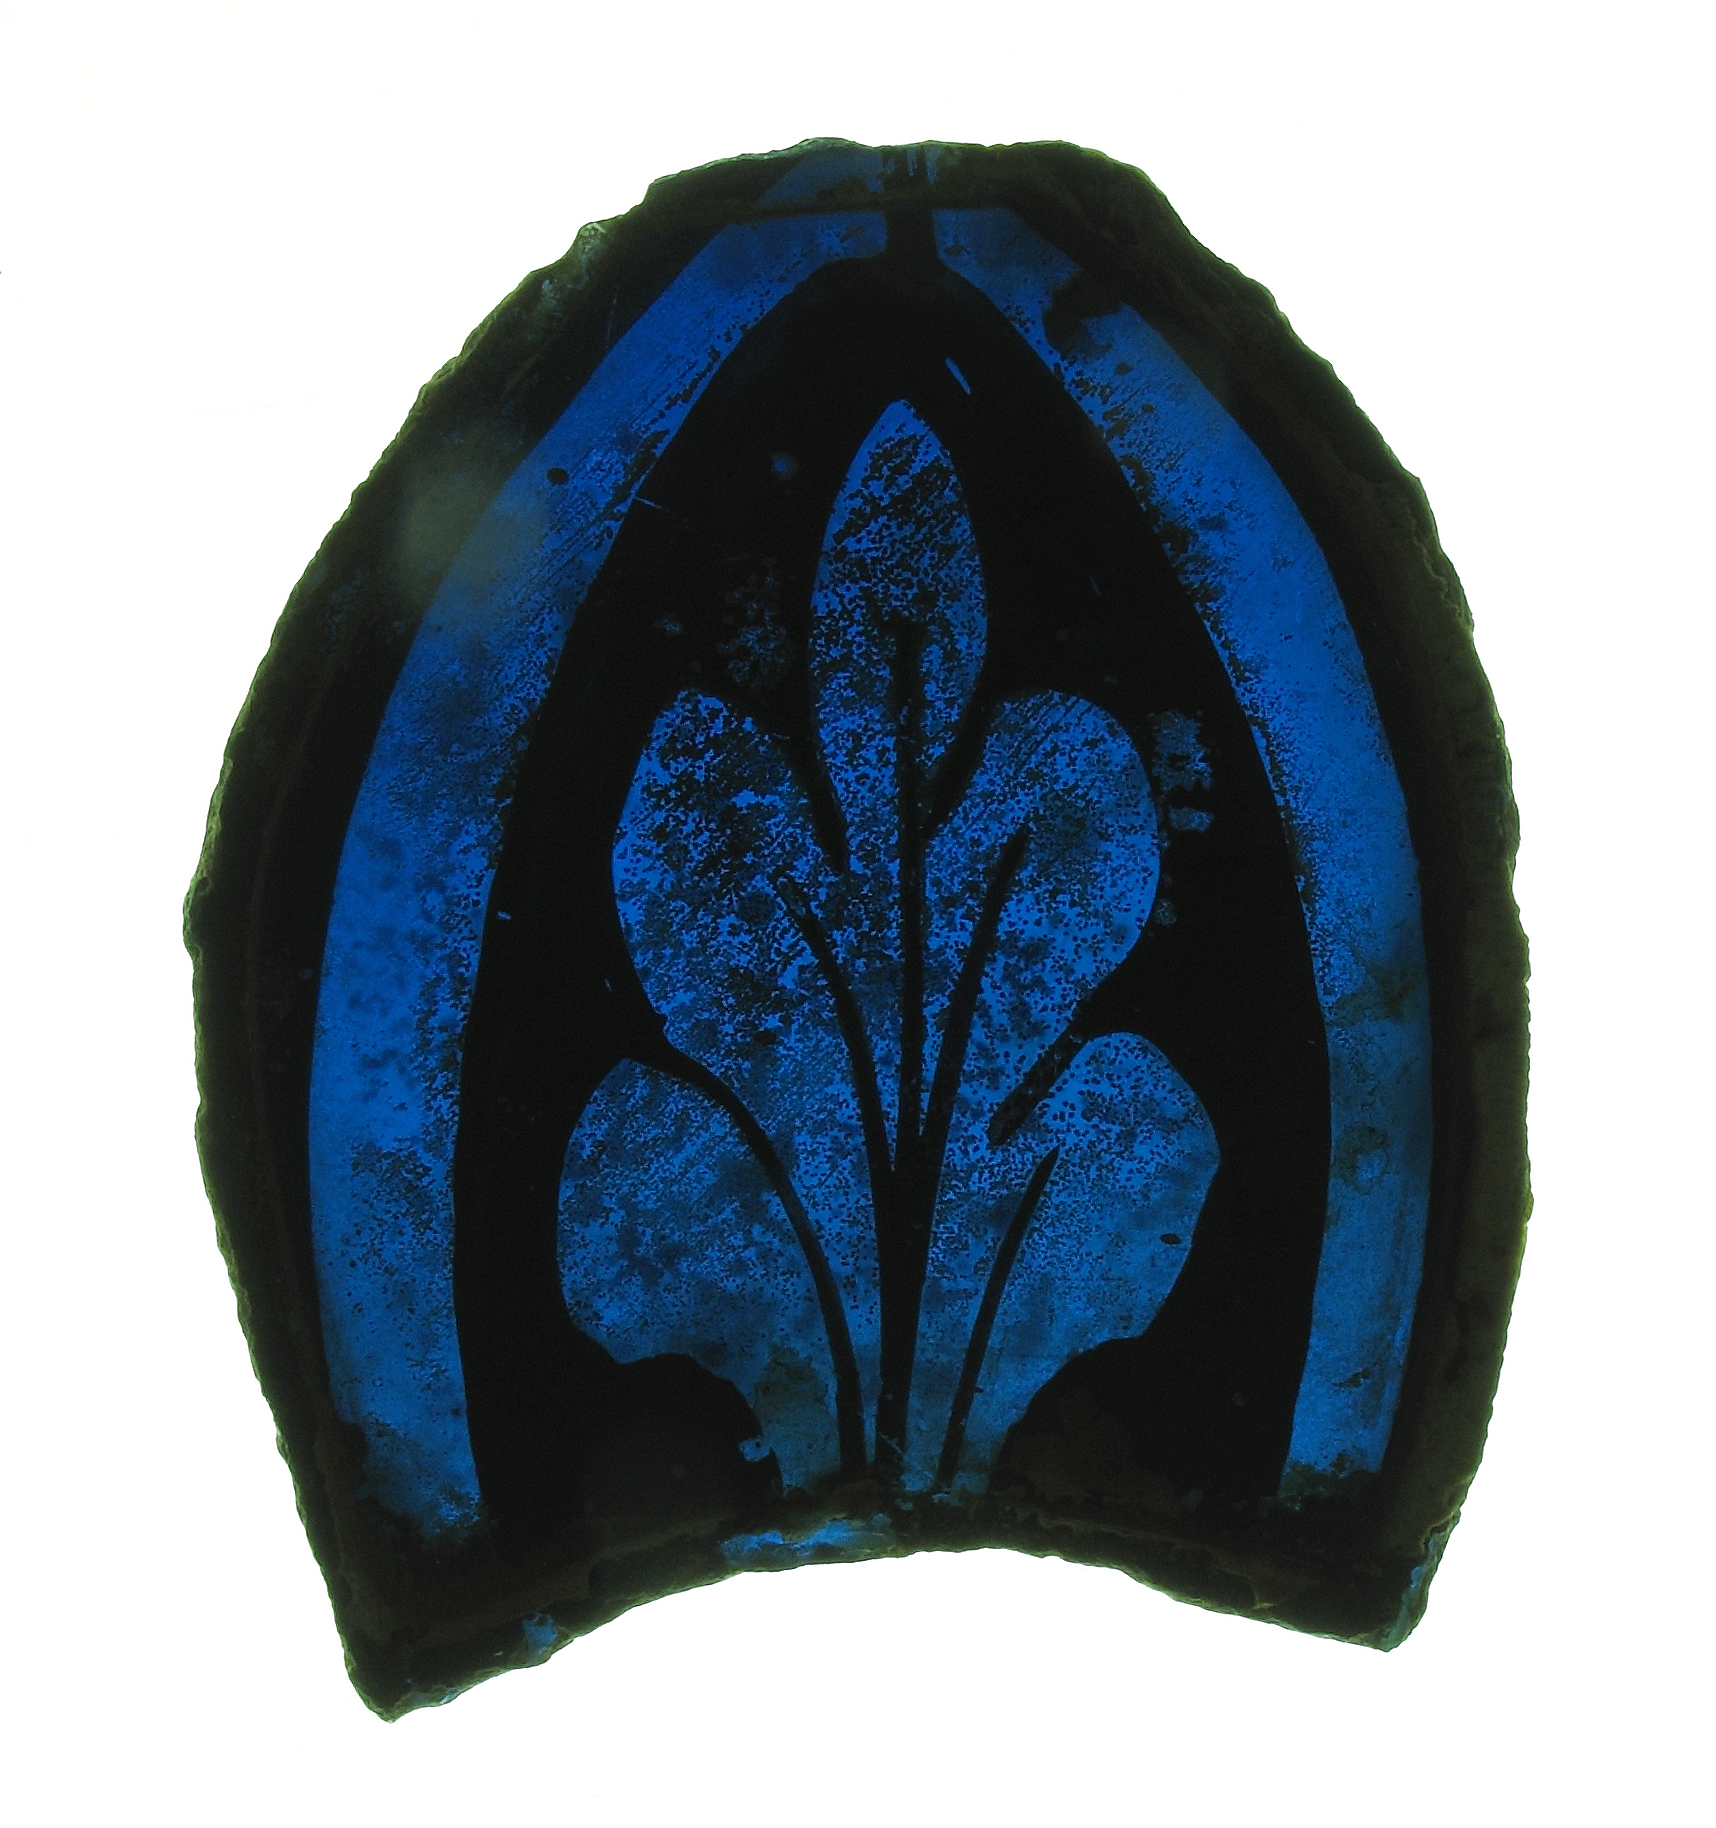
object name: fragment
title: Glass Fragment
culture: european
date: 1201-1400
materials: glass, metal